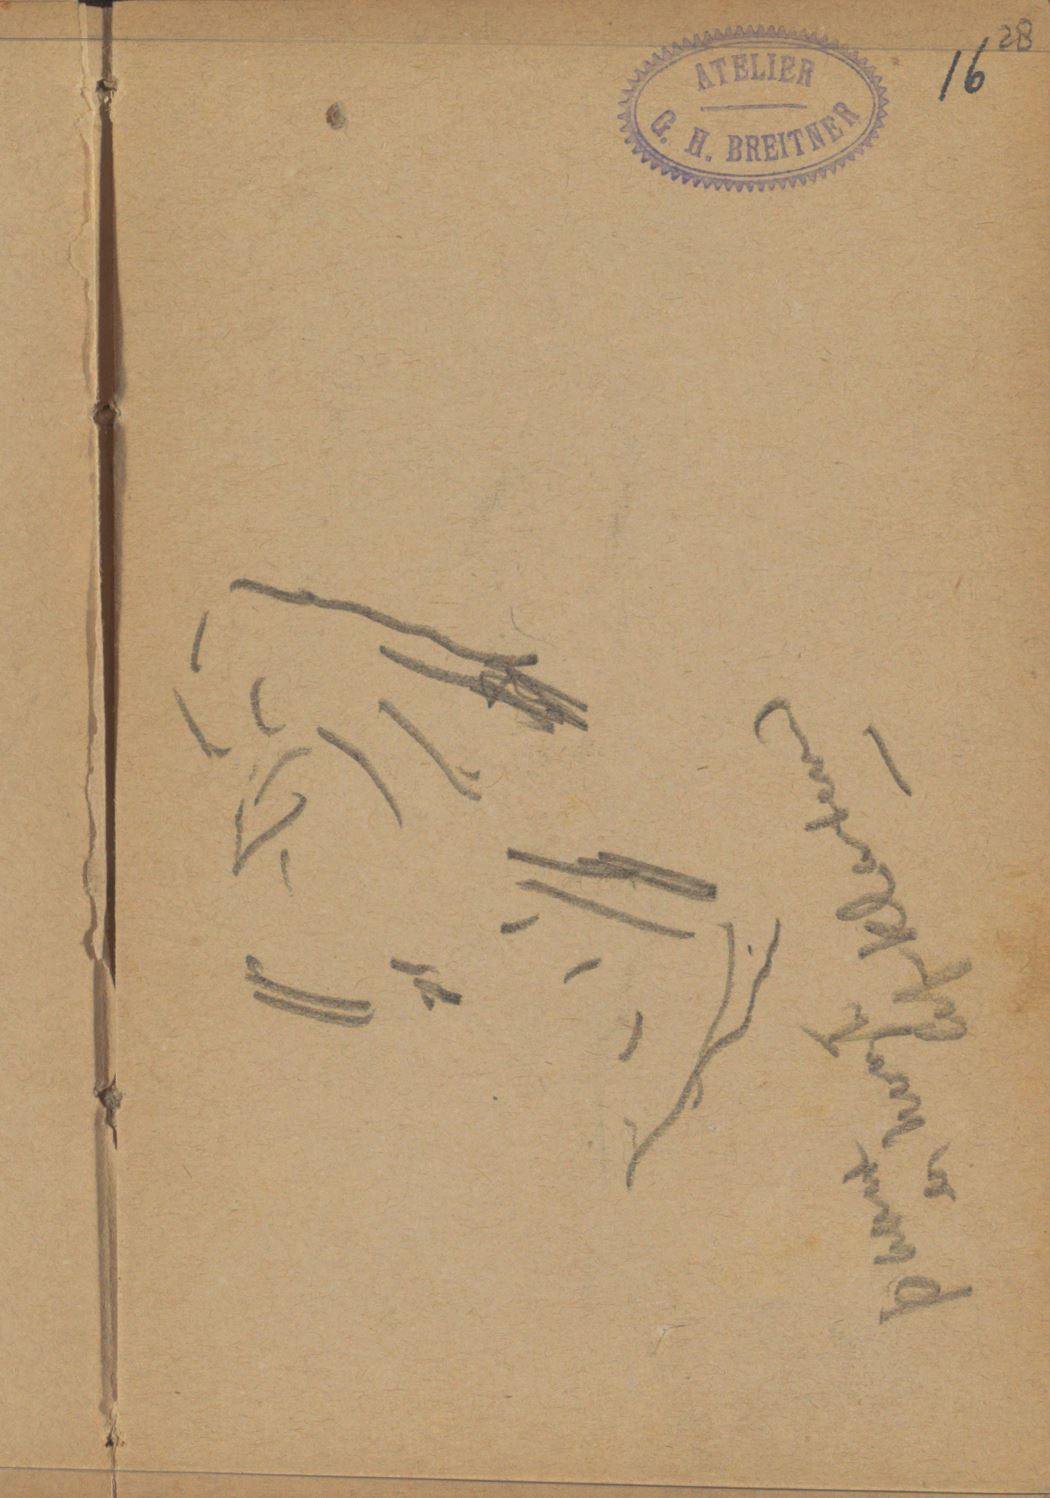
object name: sketchbook leaf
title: Paard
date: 1887-1891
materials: paper, pencil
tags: horse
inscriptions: annotation: ‘paard/ [...]’, workshop stamp: Lugt 291d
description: Pagina 28 uit een schetsboek met 83 bladen.